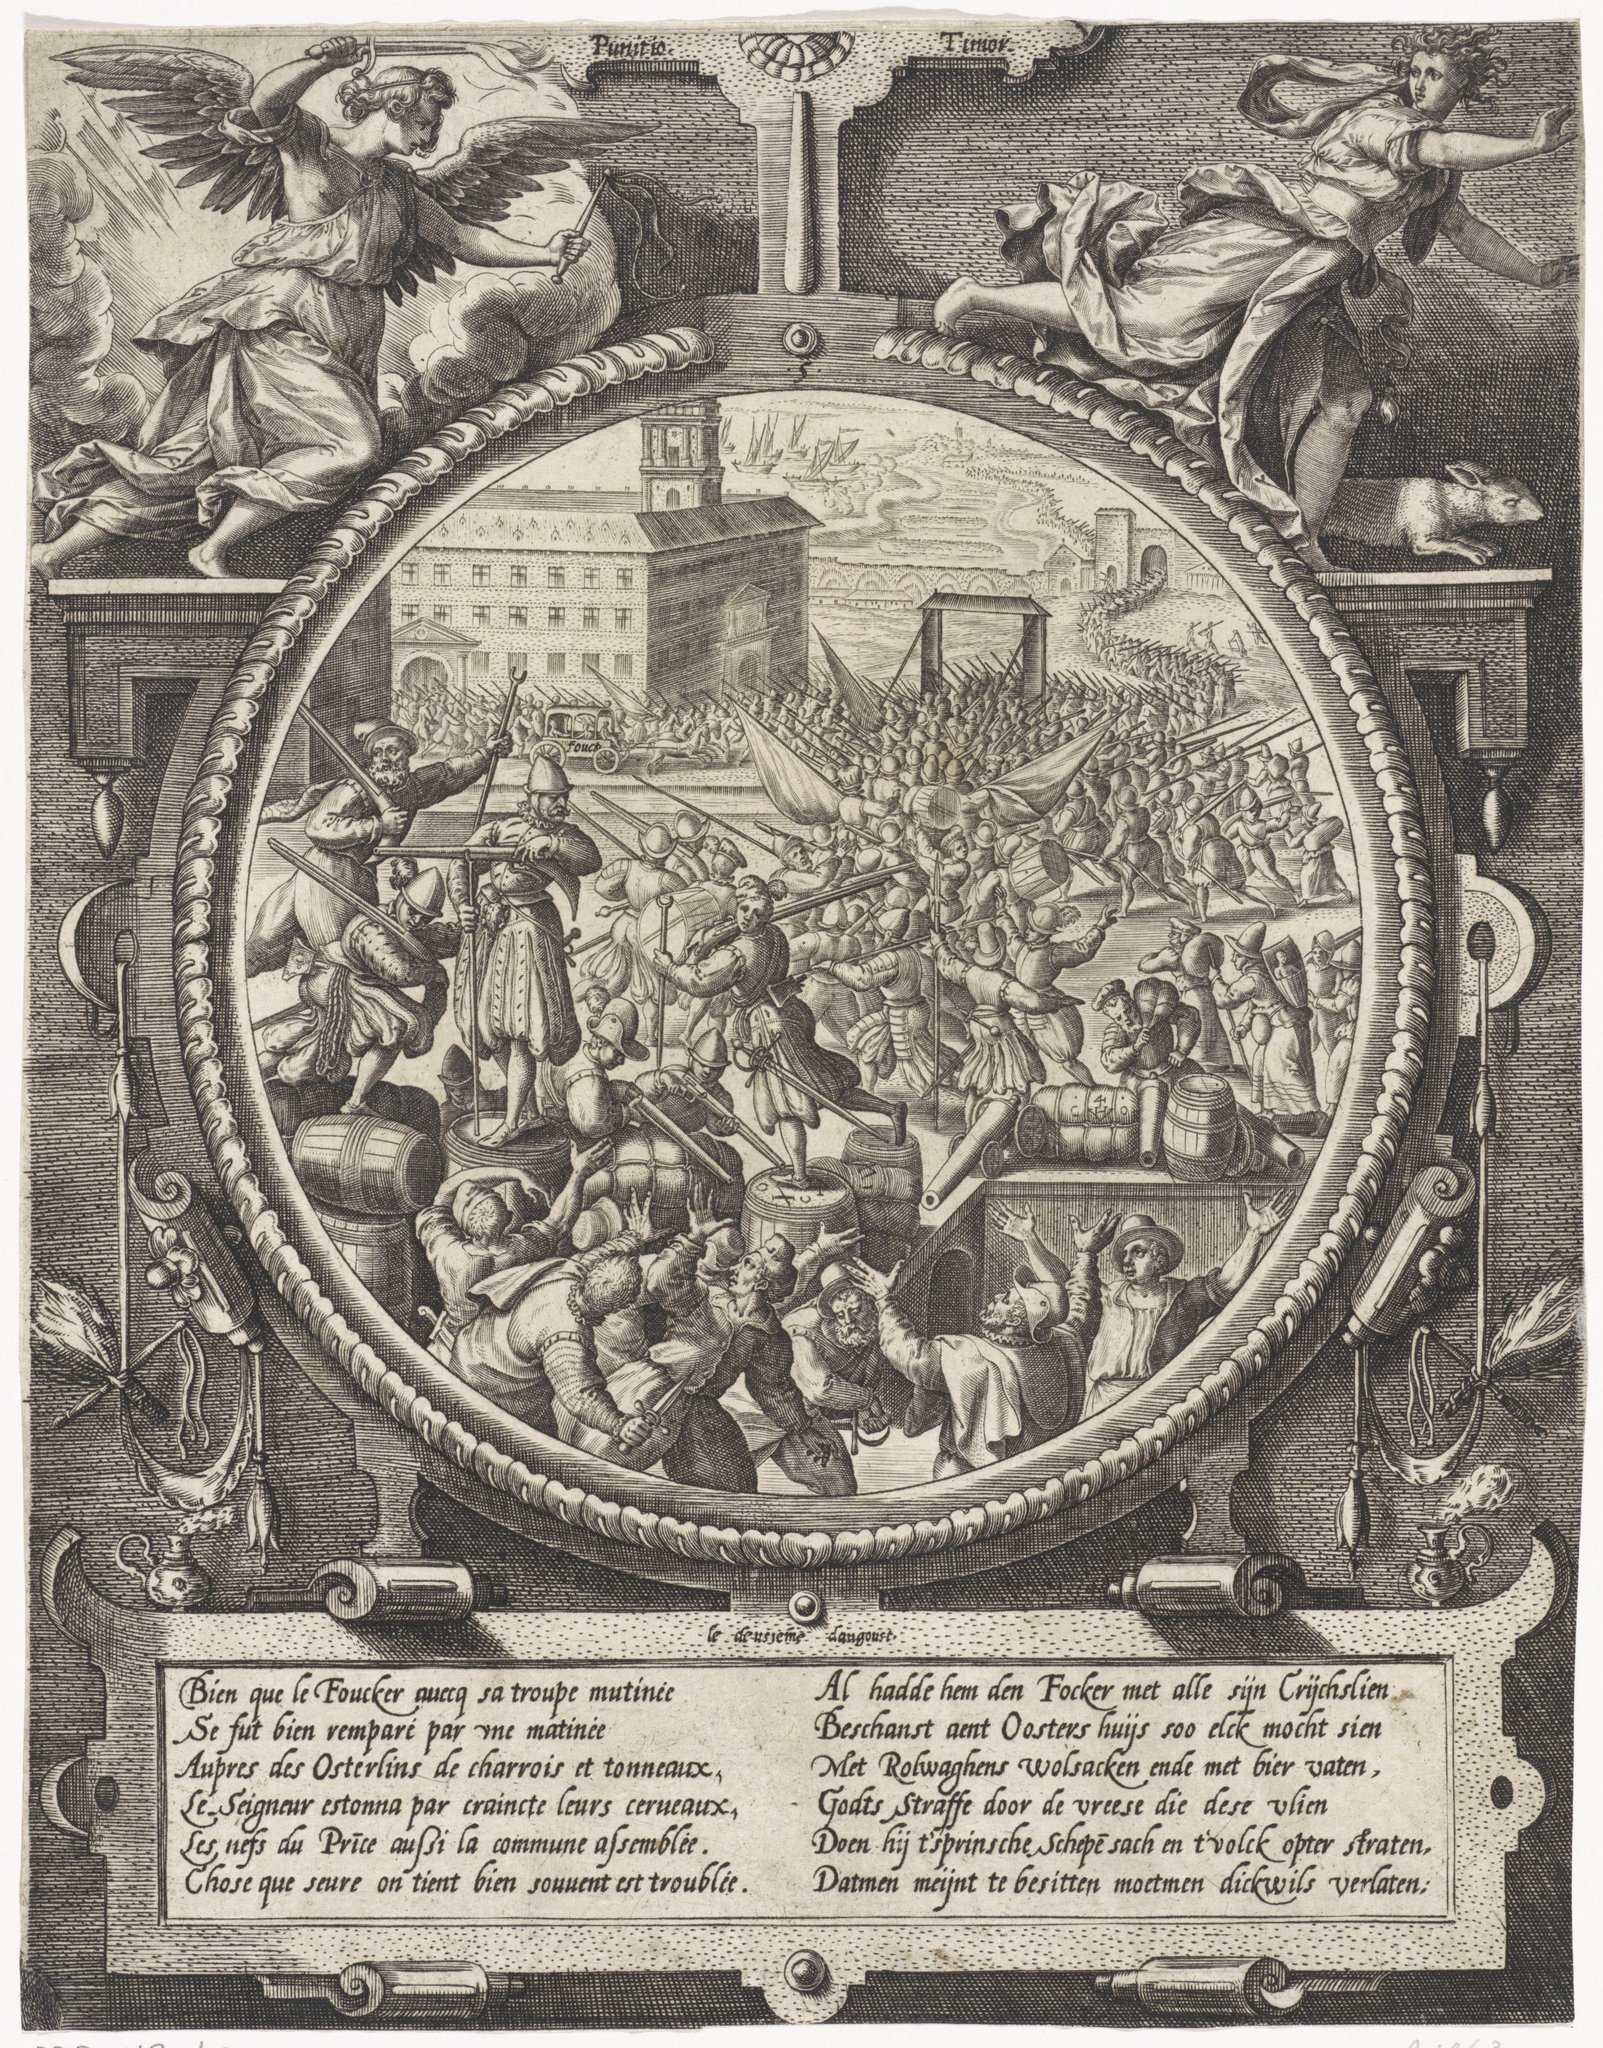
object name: propagandaprent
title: Paniek onder de Duitse soldaten door de aankomst van enkele schepen van de prins van Oranje, 1577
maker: wierix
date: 1578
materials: paper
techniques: engraving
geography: antwerp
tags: fear, dread; 'paura', 'timidità o timore', 'timore' (ripa), plundering ~ soldiers, punishment; 'castigo', 'pena', 'punitione' (ripa)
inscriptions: collector's mark: Lugt 2228, collector's mark: Lugt 2760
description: Paniek onder de Duitse soldaten door de aankomst van enkele schepen van de prins van Oranje, 2 augustus 1577. Soldaten met hun buit op straat voor het Oosters Huis. Voorstelling in een rond medaillon met ornamentale allegorische omlijsting met bovenaan de zittende vrouwelijke personificaties van Bestraffing (Punitio) en Vrees (Timor). Onderaan een cartouche met 2 verzen van elk 6 regels in het Frans en Nederlands.